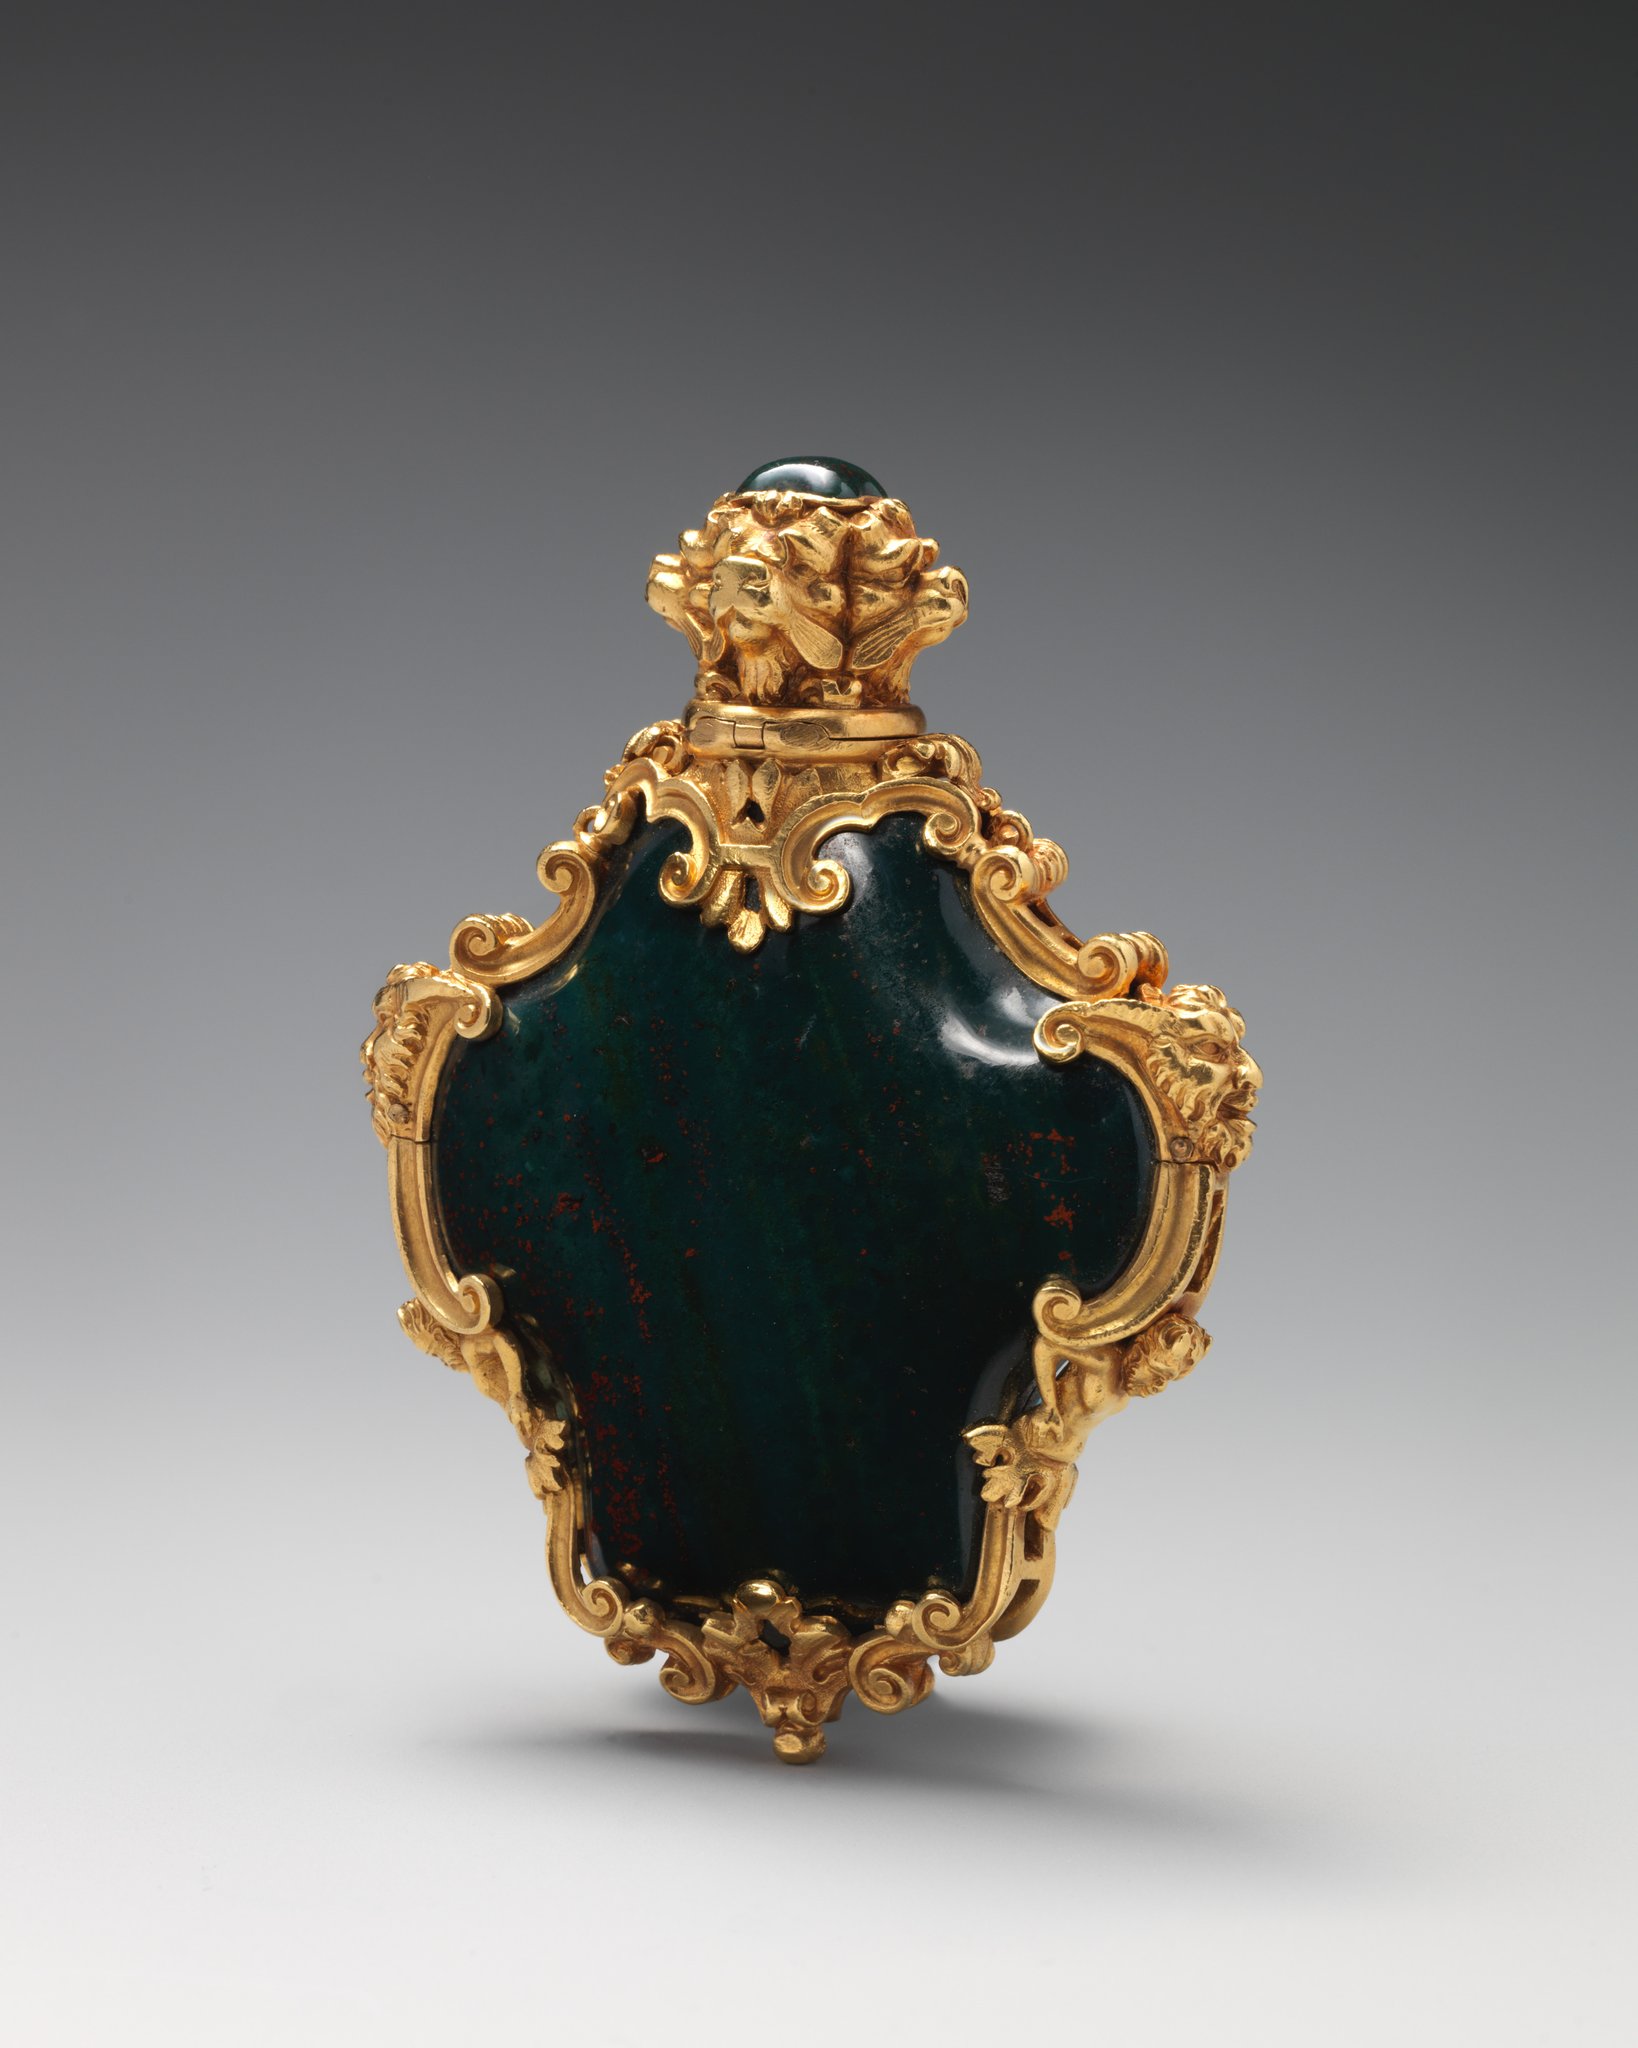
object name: bottle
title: Perfume bottle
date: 1760-1769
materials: gold